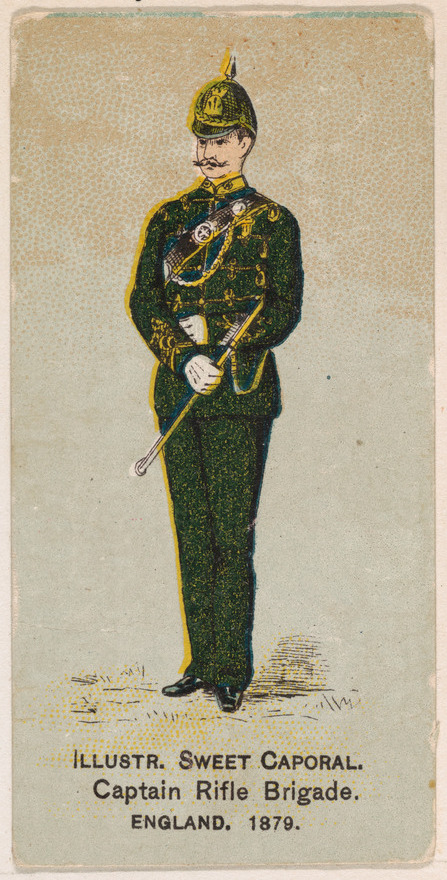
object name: print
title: Captain, Rifle Brigade, England, 1879, from the Military Series (N224) issued by Kinney Tobacco Company to promote Sweet Caporal Cigarettes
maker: kinney brothers tobacco company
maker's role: publisher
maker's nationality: american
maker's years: 1869-2011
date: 1888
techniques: color lithograph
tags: military,men